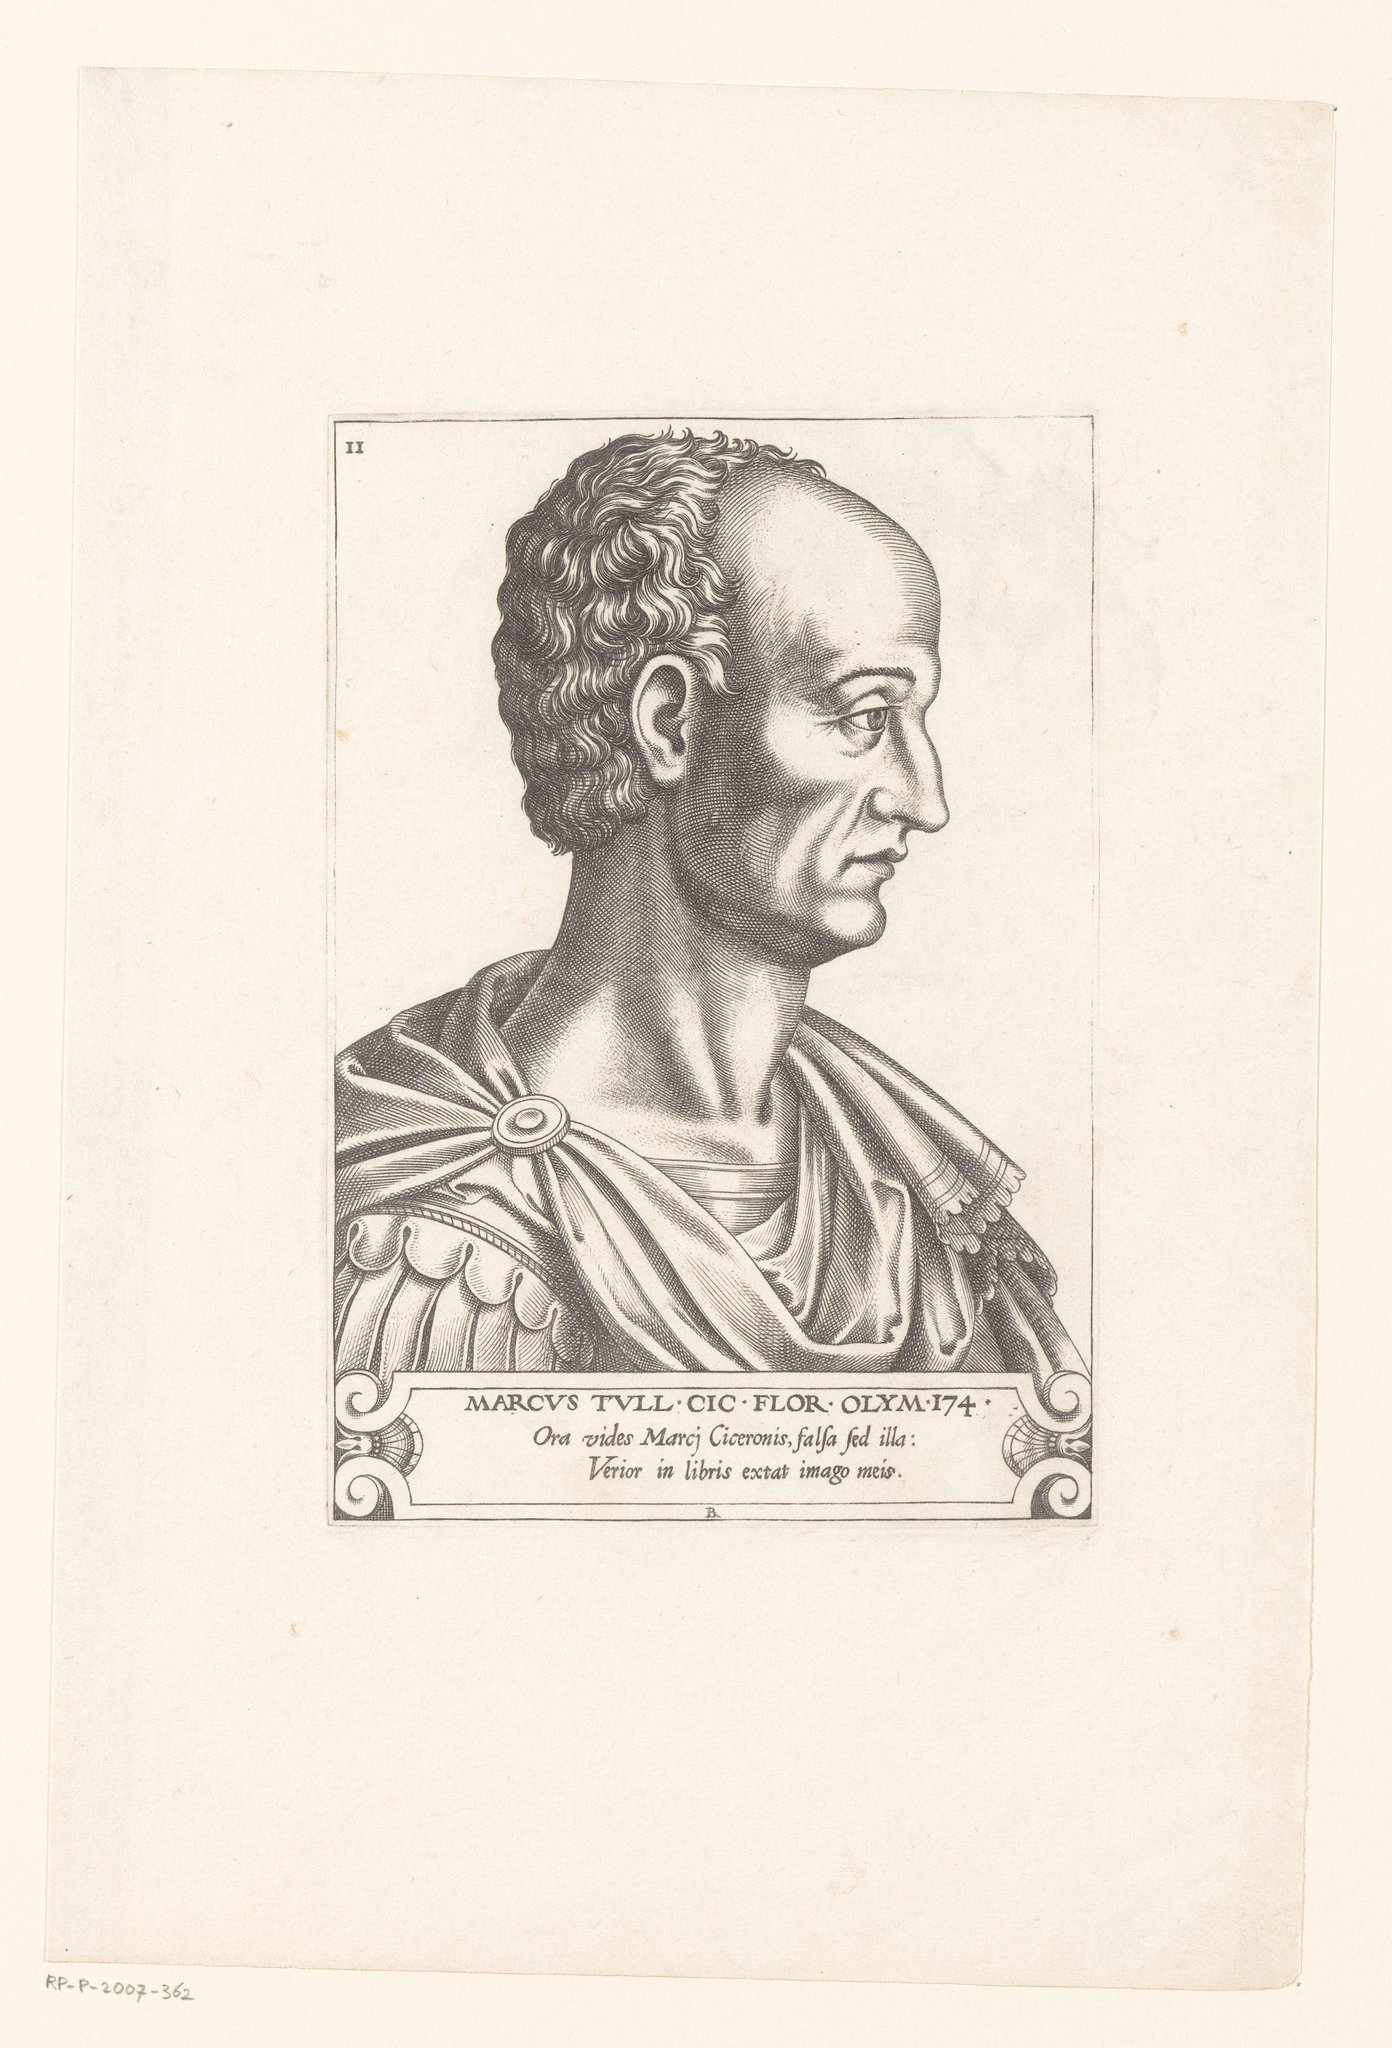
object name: print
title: Illustrium philosophorum et poetarum effigies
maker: rené boyvin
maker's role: print maker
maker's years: 1525-1598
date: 1566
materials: paper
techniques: engraving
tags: marcus tullius cicero, (story of) cicero, historical persons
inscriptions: collector's mark: Lugt 2760, collector's mark: Lugt 2228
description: Maakt deel uit van een serie van twaalf portretten van Griekse en Romeinse filosofen, getiteld 'Illustrium philosophorum et poetarum effigies', uitgegeven in 1566 door P. de Roville in Parijs.